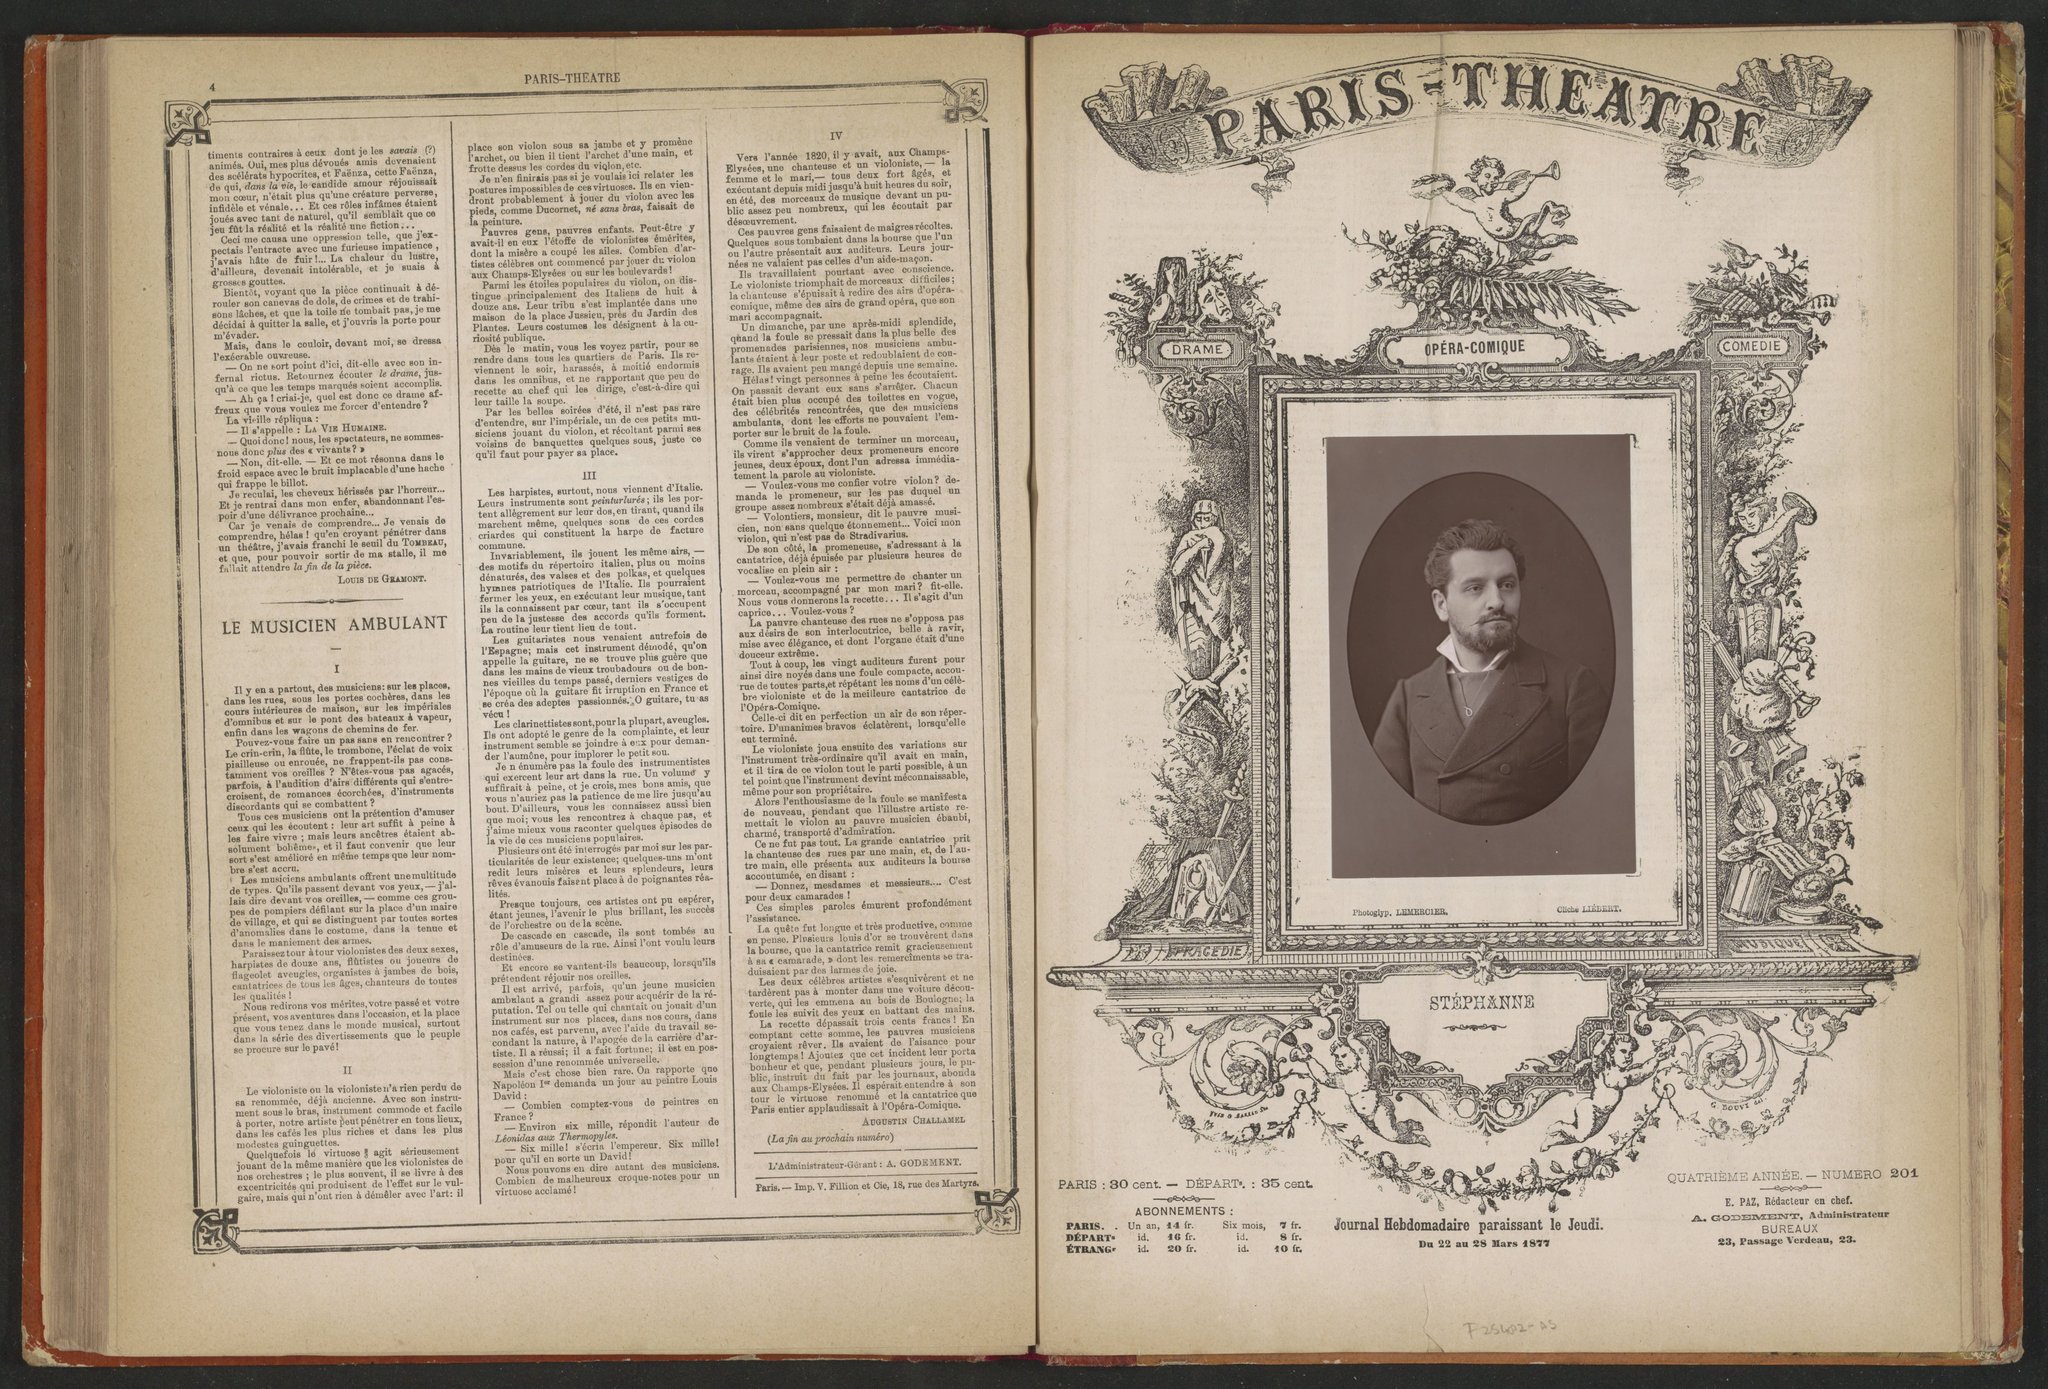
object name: page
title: Stephanne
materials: paper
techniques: woodburytype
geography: france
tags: portrait of opera-singer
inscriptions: inscription: ‘Journal Hebdomadaire paraissant le Jeudi, Du 22 au 28 Mars 1877’, number: ‘Numéro 201’